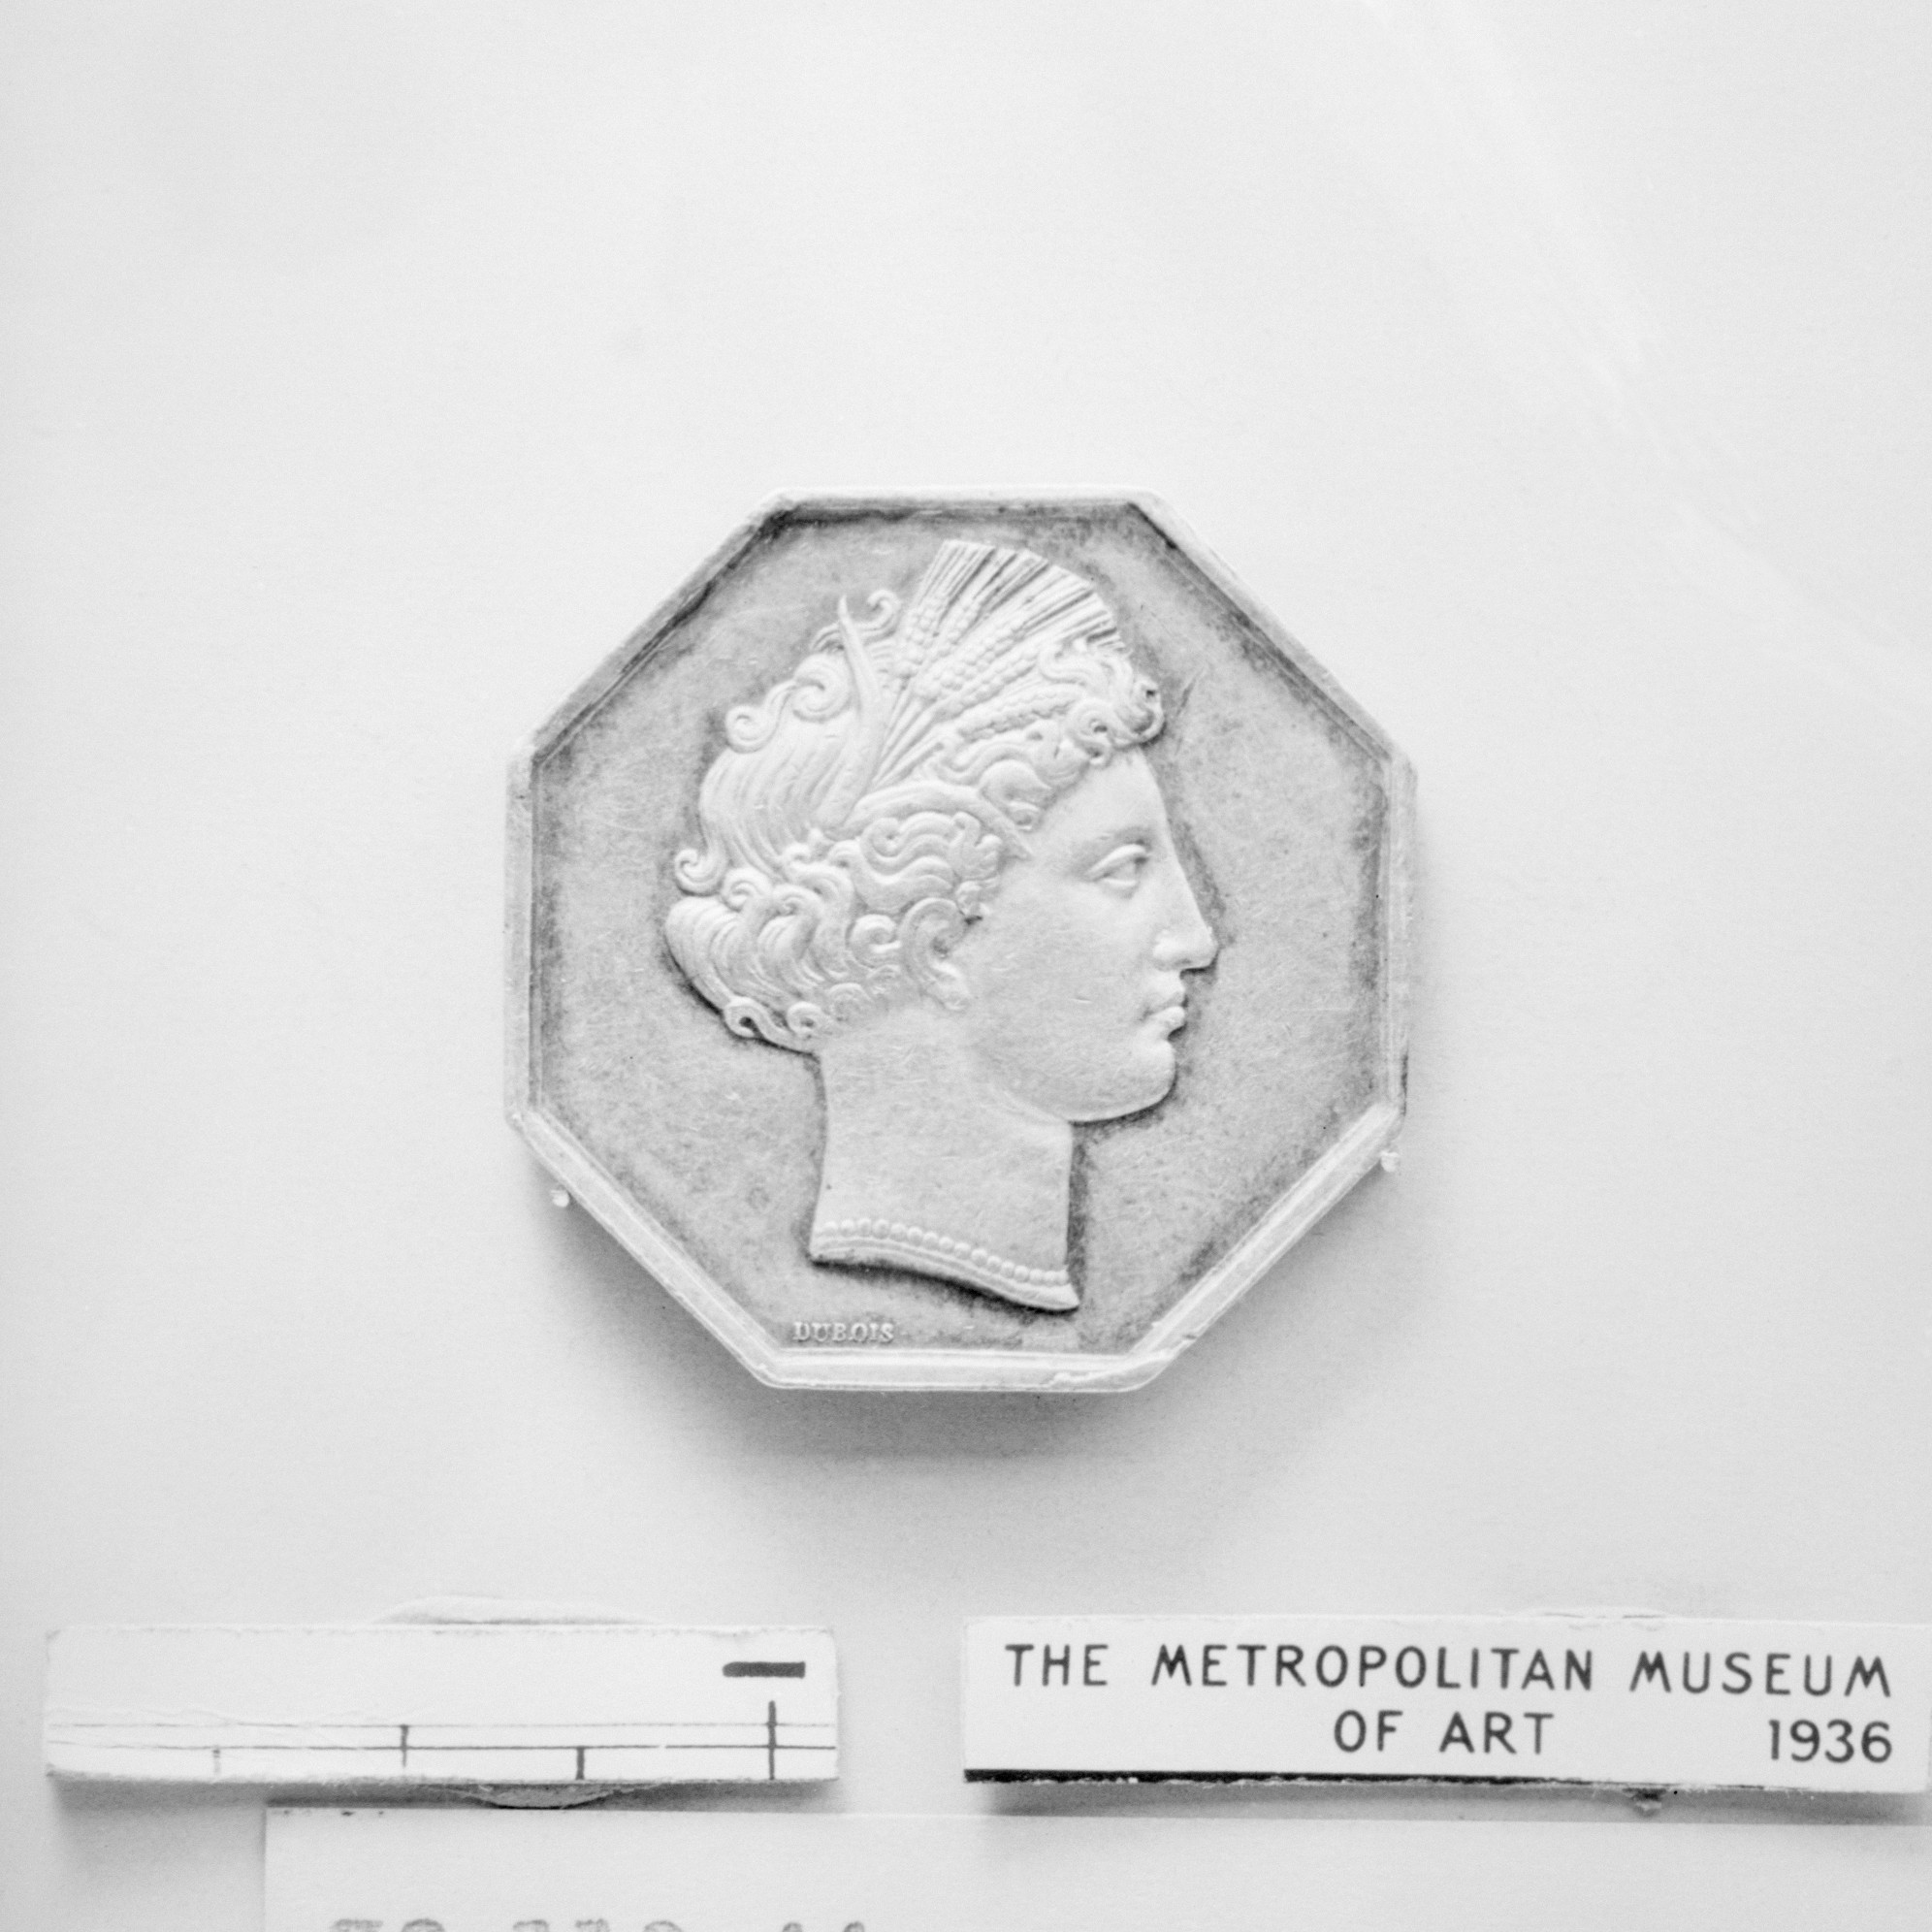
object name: medal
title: Commemorating the Agricultural Assembly of Amiens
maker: rené dubois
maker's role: artist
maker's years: 1737-1799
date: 1860-1879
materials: silver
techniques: struck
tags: men,profiles